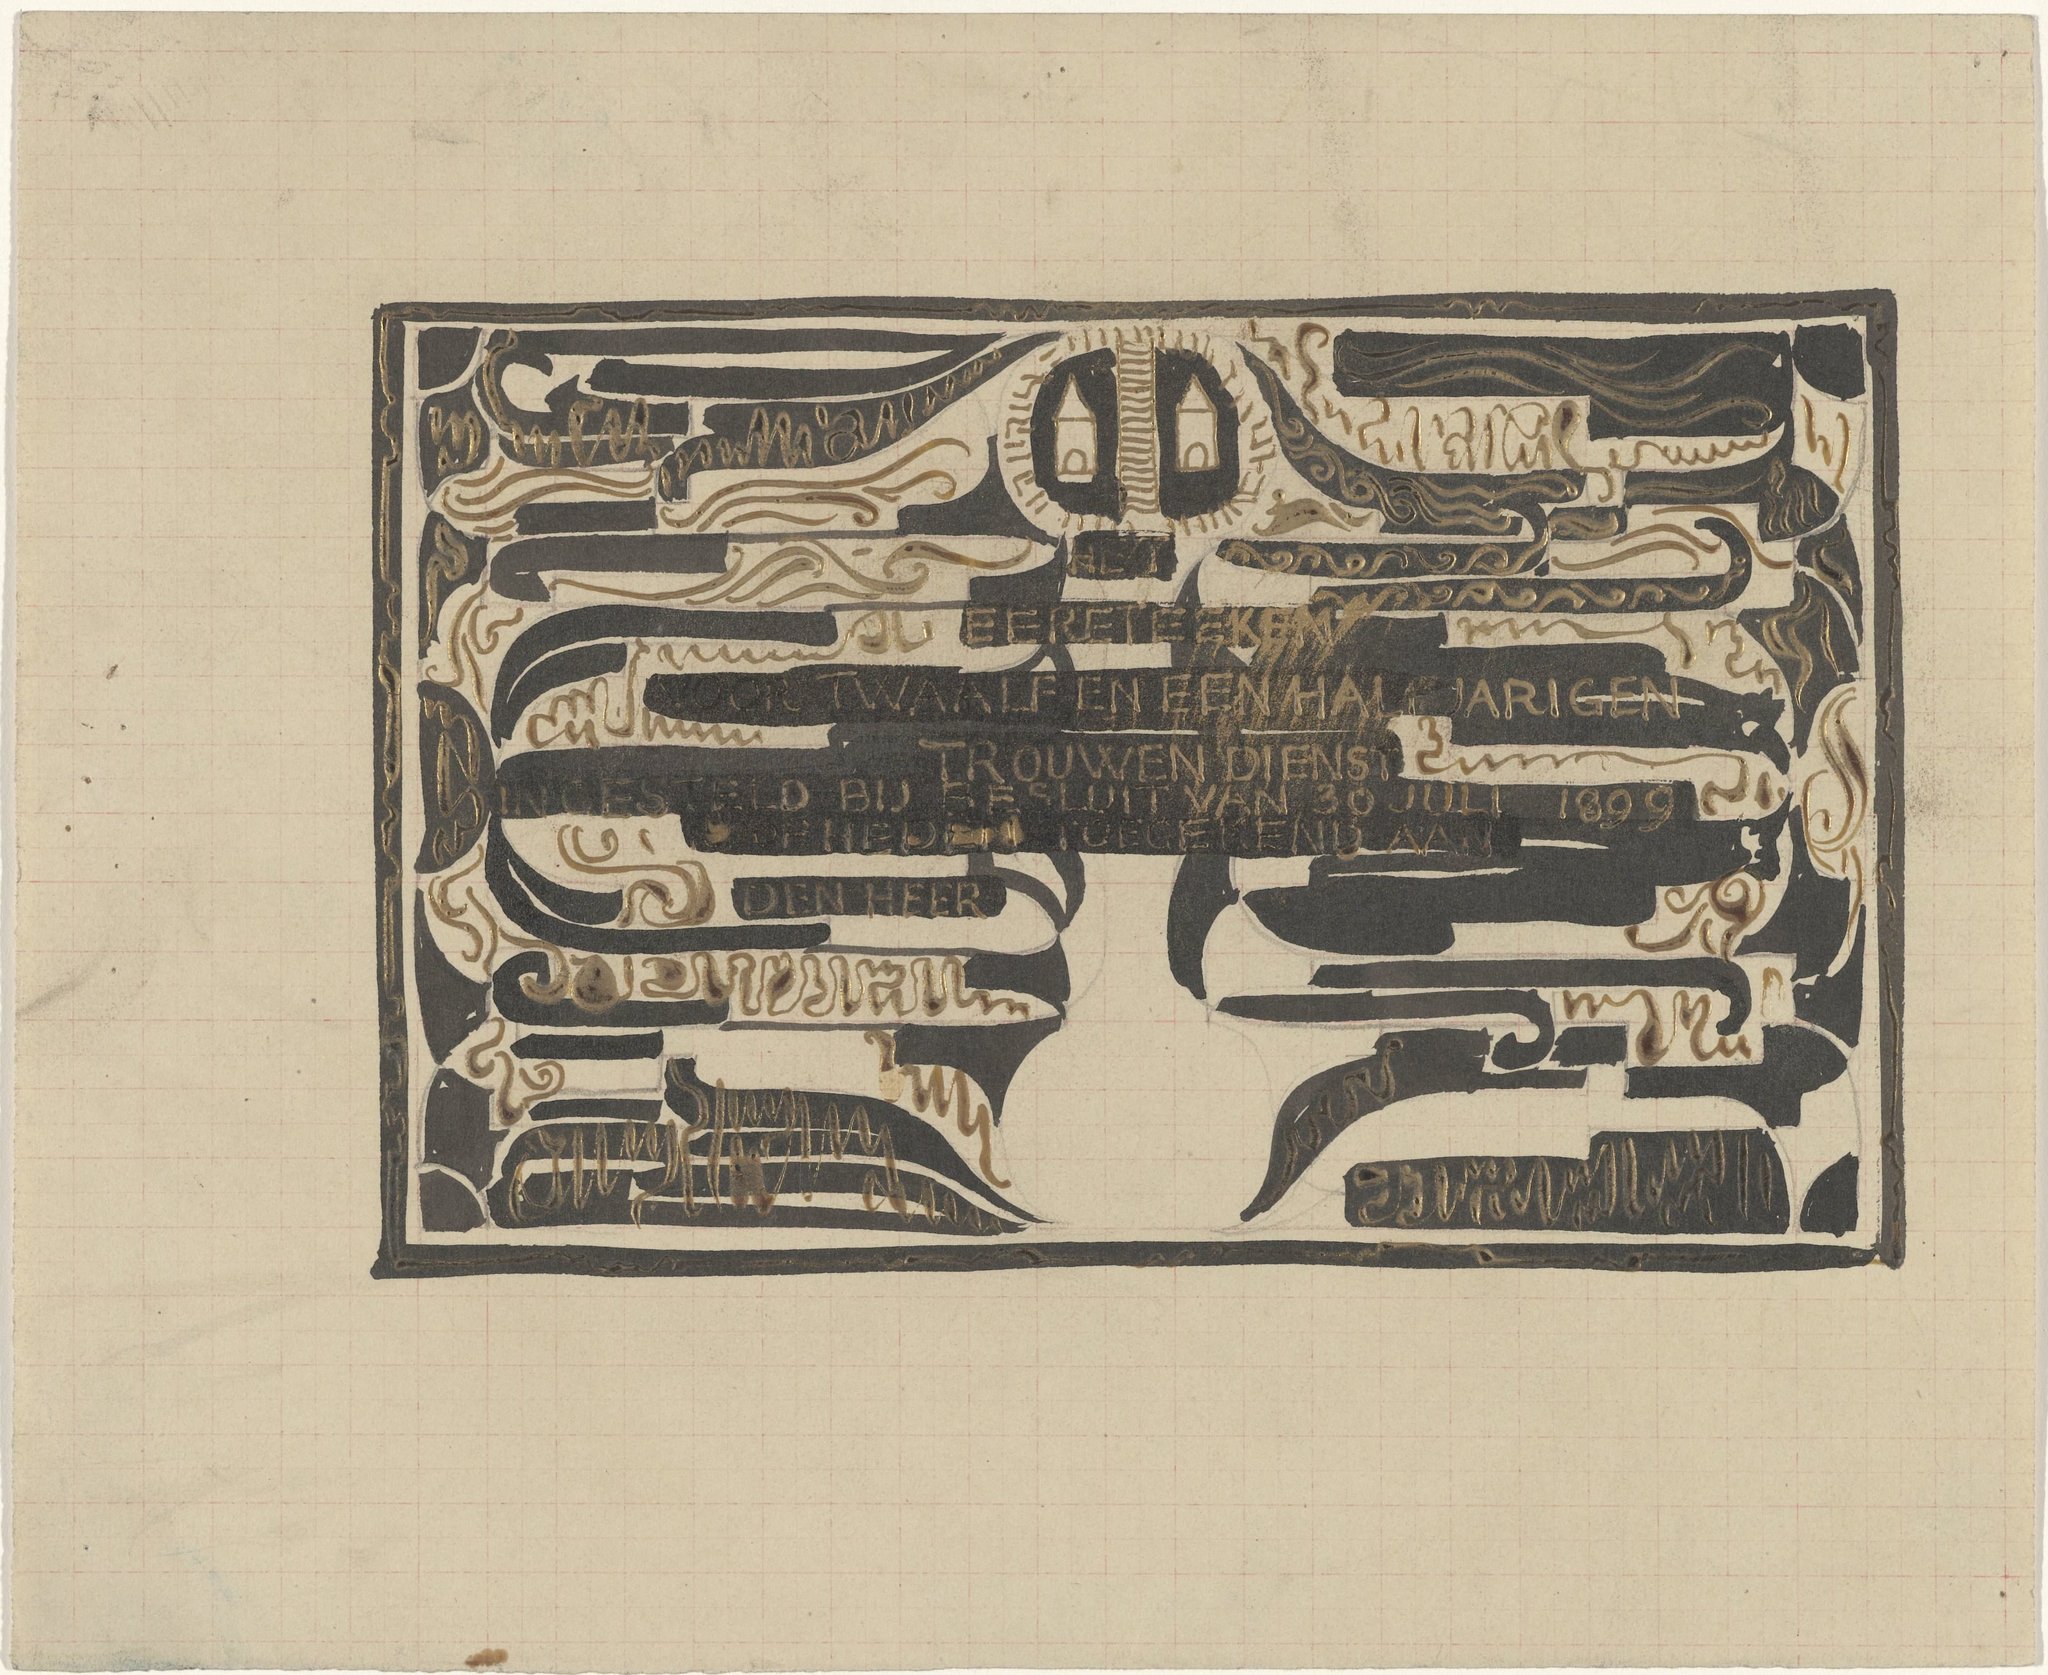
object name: design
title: Ontwerp voor een oorkonde ter gelegenheid van twaalf-en-een-halfjarige dienst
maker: carel adolph lion cachet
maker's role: draughtsman, print maker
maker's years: 1864-1945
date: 1874-1945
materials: paint, paper, pencil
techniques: brush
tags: ornamental decoration ~ printed matter, book